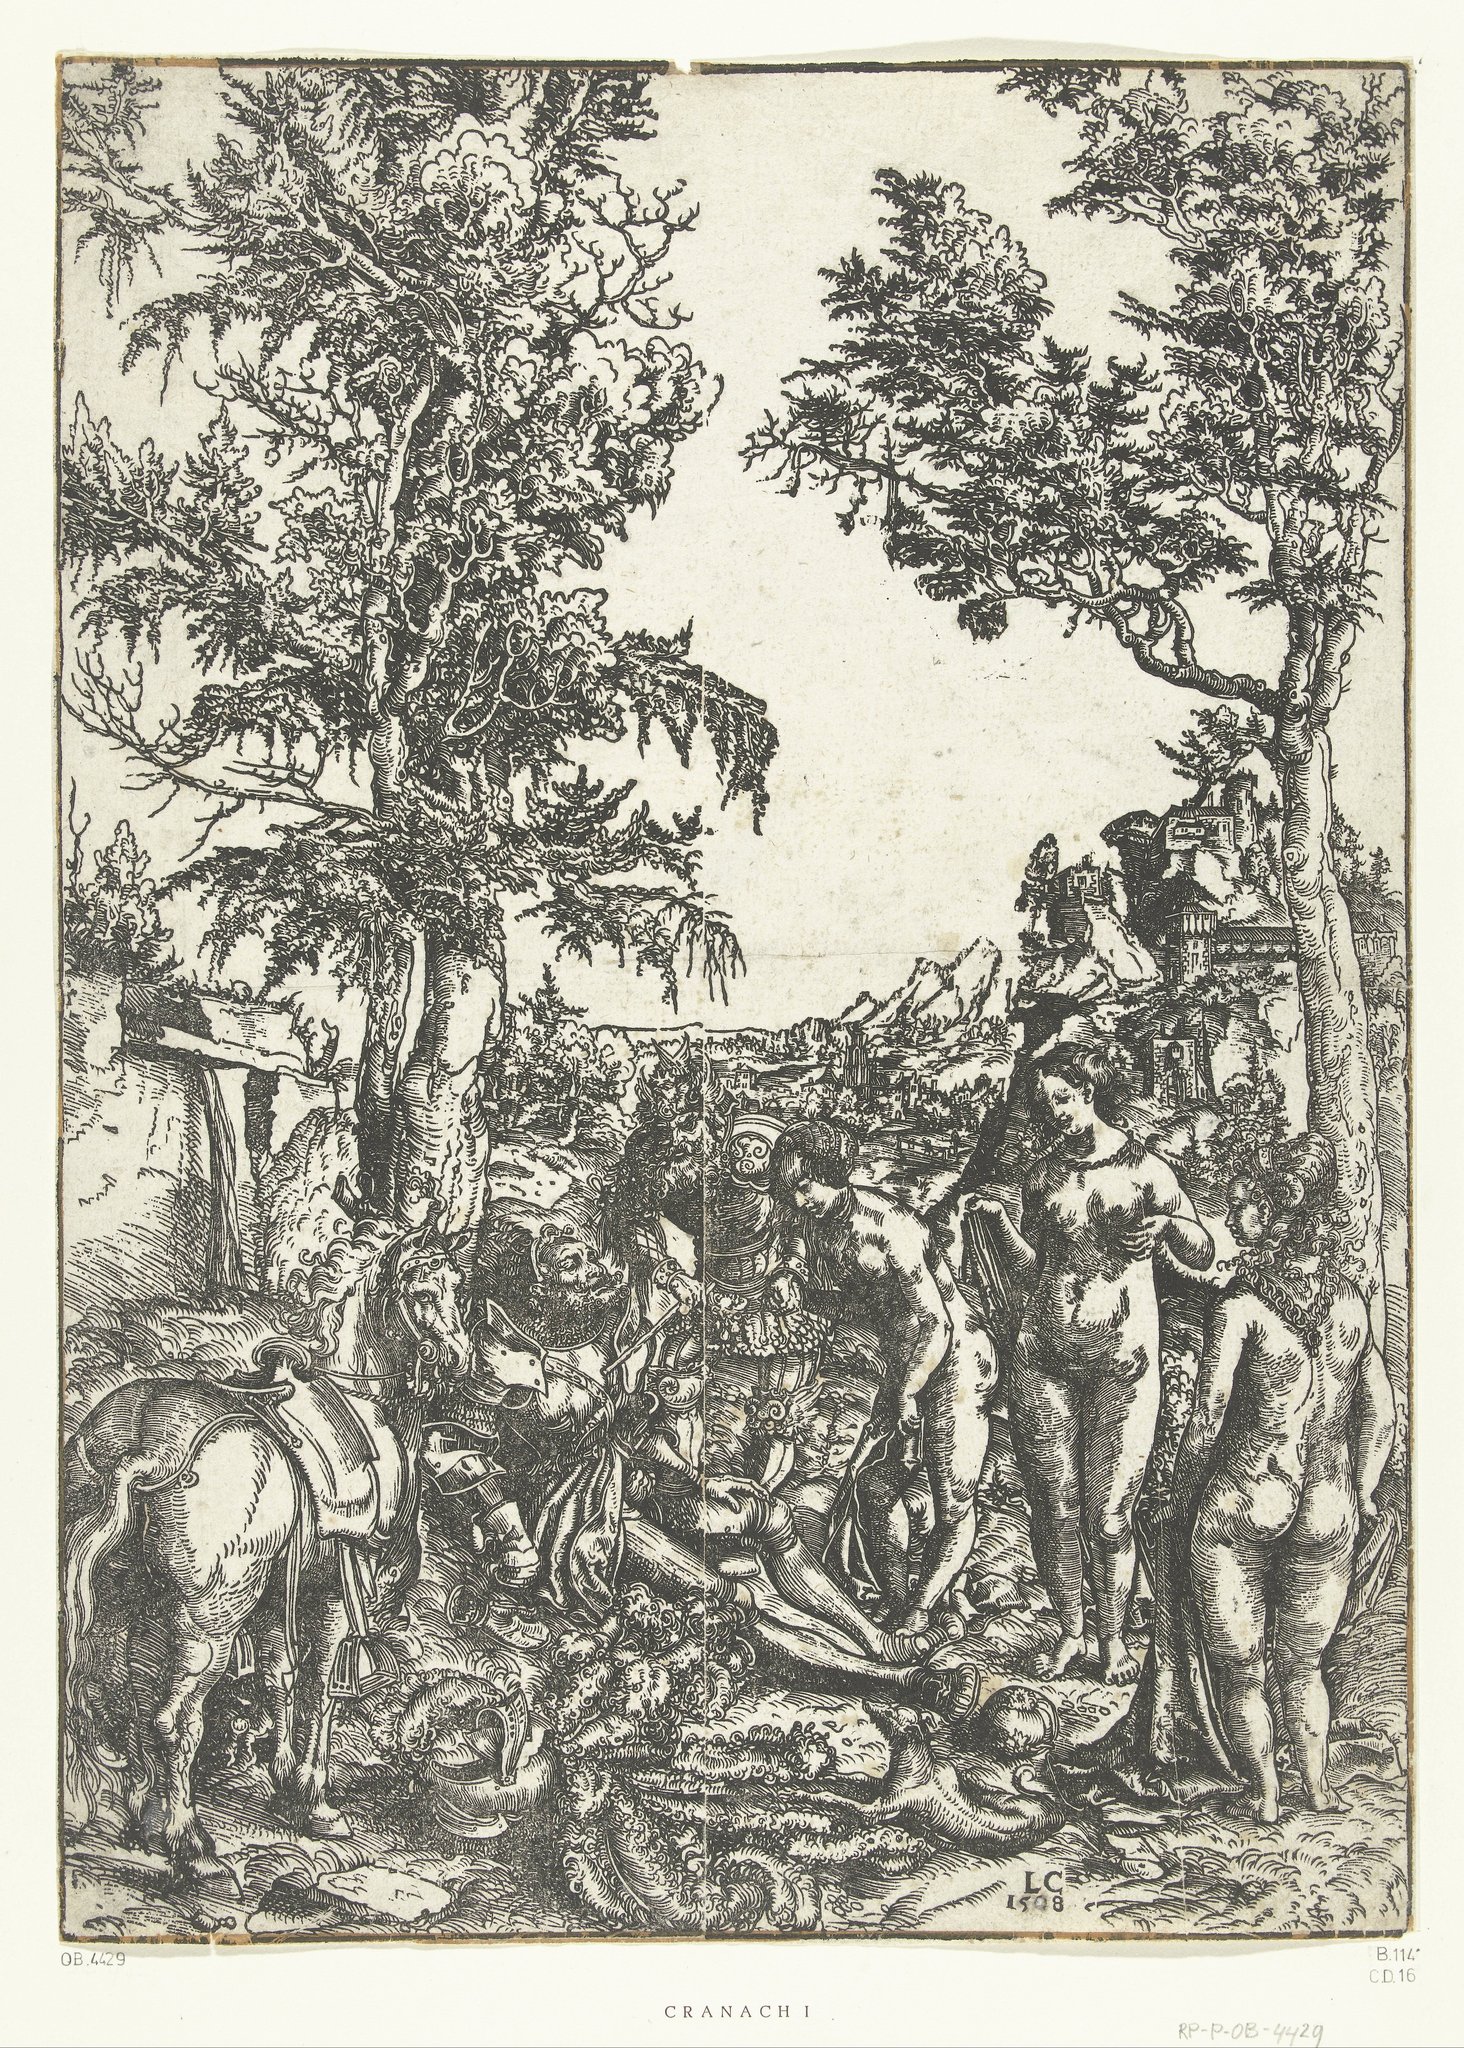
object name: print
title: Oordeel van Paris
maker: lucas cranach (i)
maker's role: draughtsman, print maker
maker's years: 1472-1553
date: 1508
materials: paper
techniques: woodcut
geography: germany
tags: the judgement of paris (mercury present)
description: Mercurius wekt de slapende Paris zodat hij kan beslissen welke van de drie godinnen Juno, Minerva of Venus de mooiste is. De vrouwen zijn hier niet door attributen van elkaar te onderscheiden.